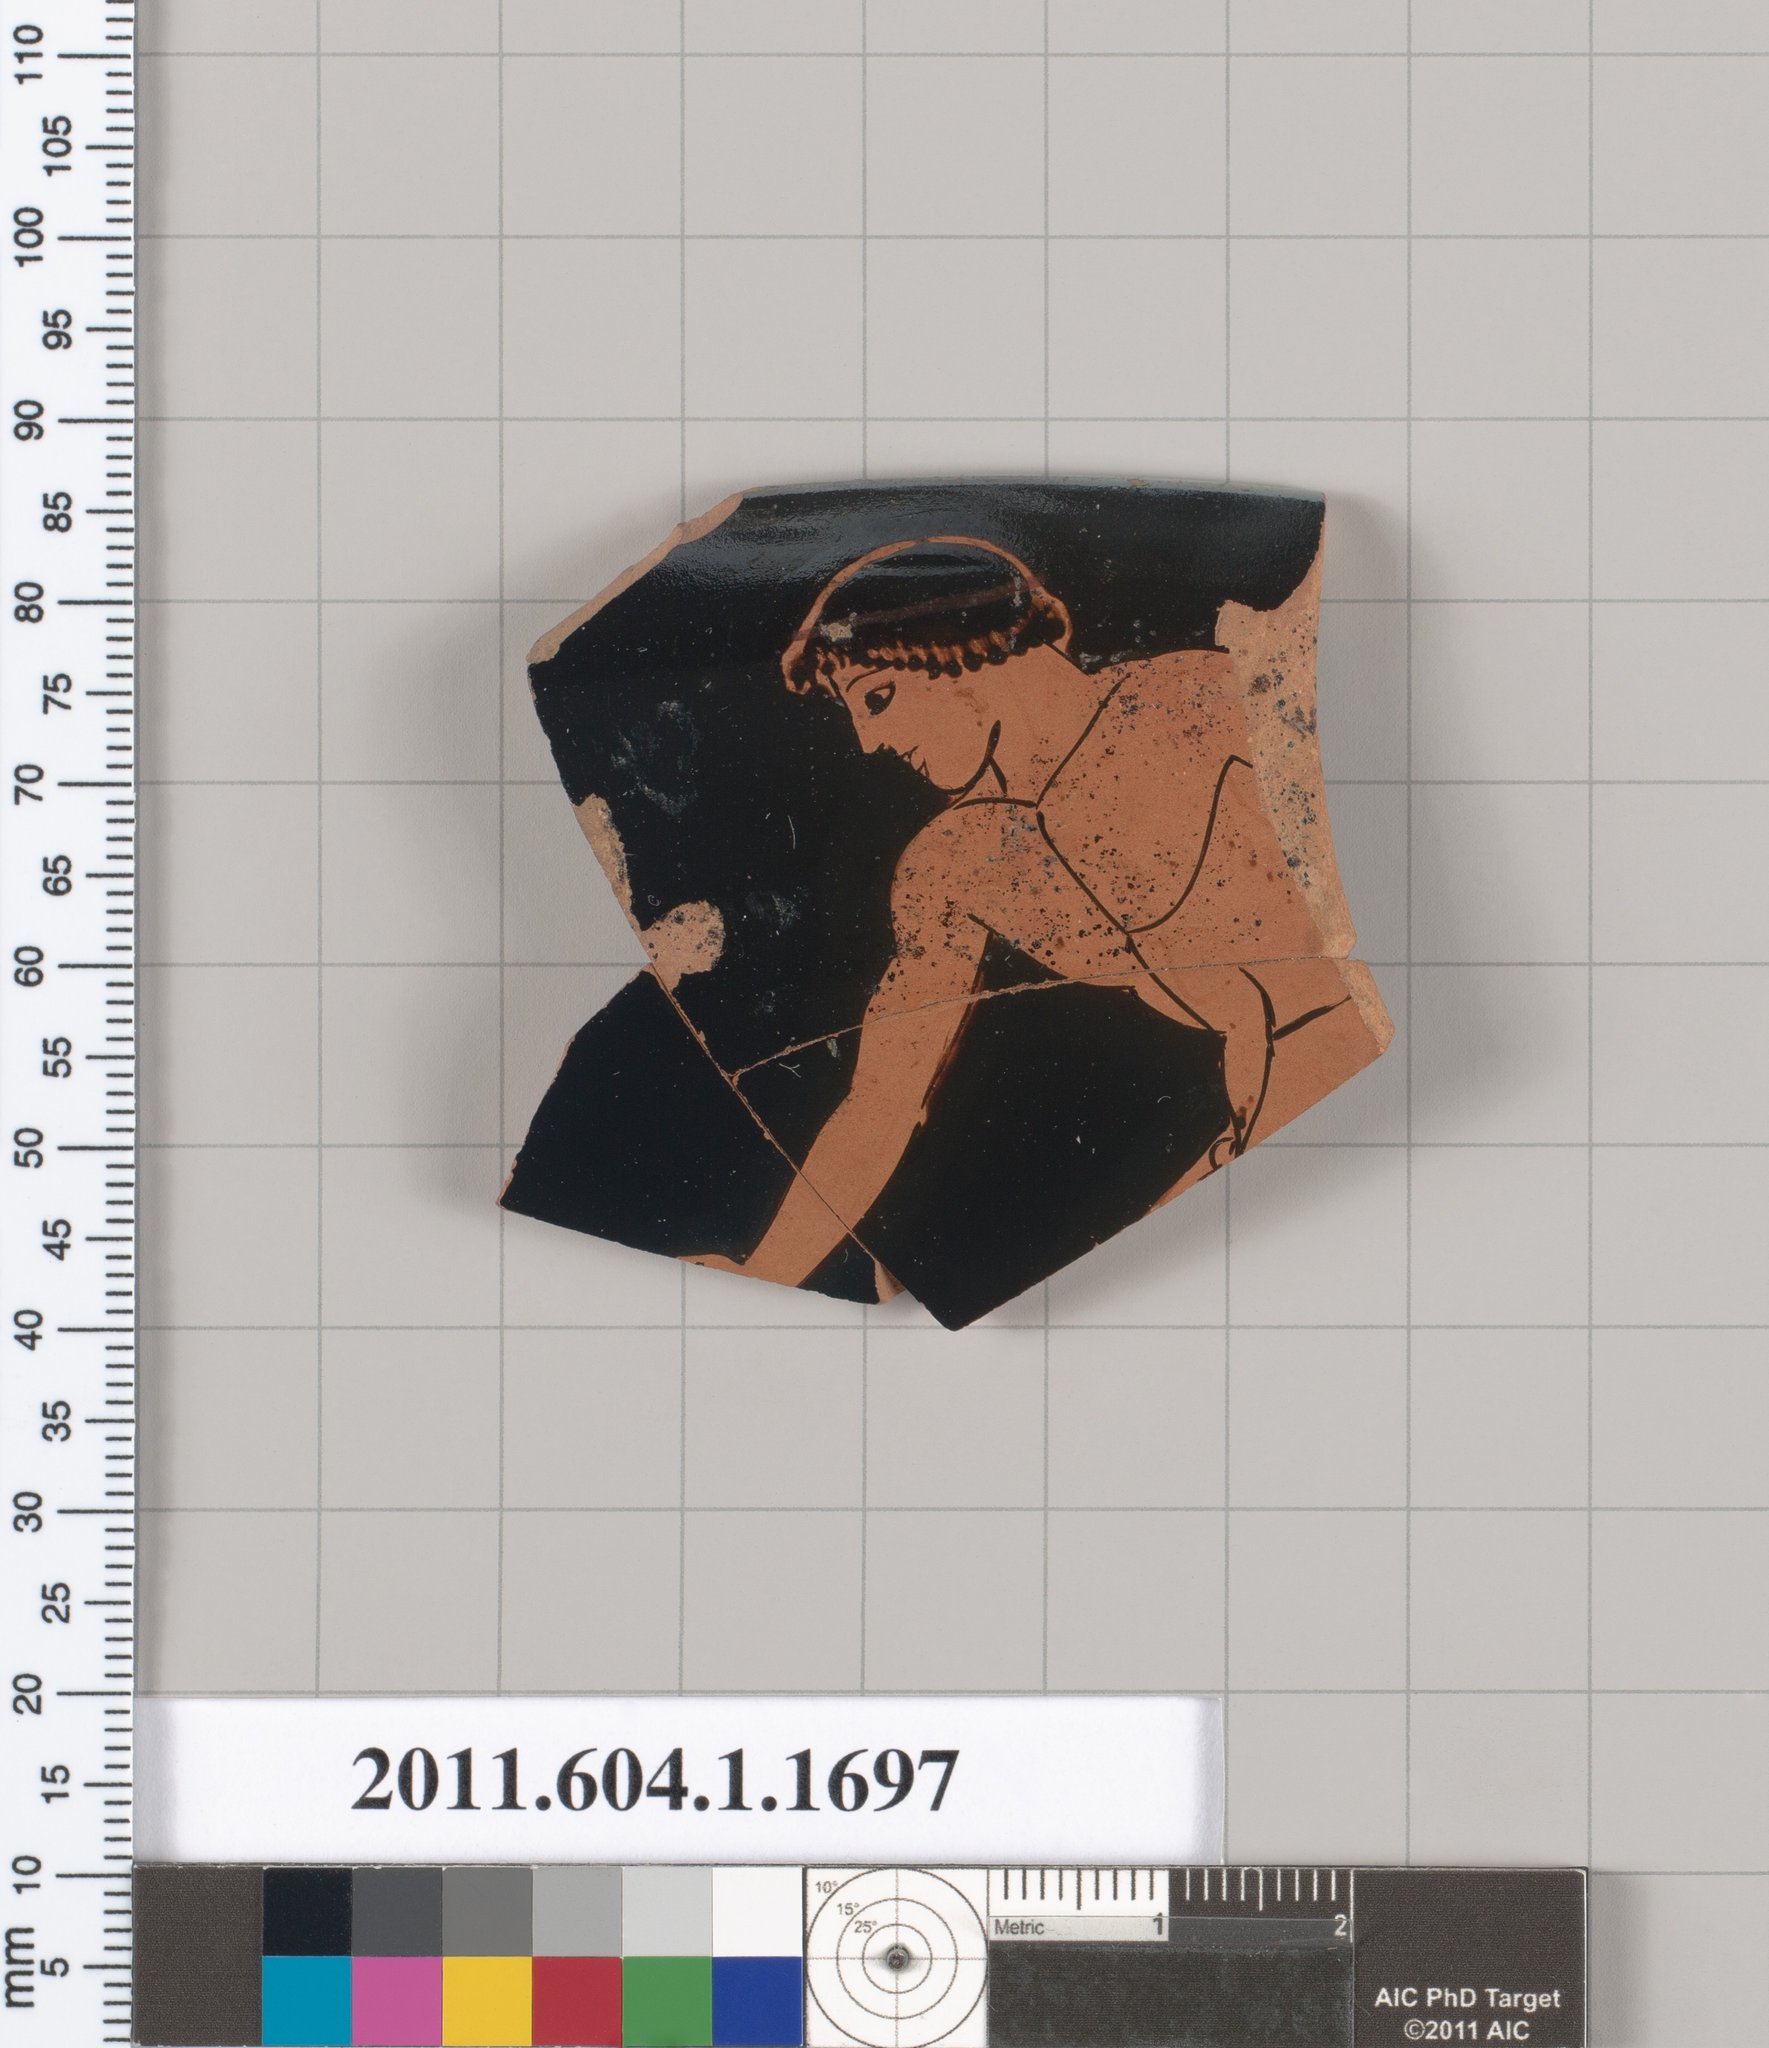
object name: kylix fragment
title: Terracotta rim fragment of a kylix (drinking cup)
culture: greek, attic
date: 480-470 BCE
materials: terracotta